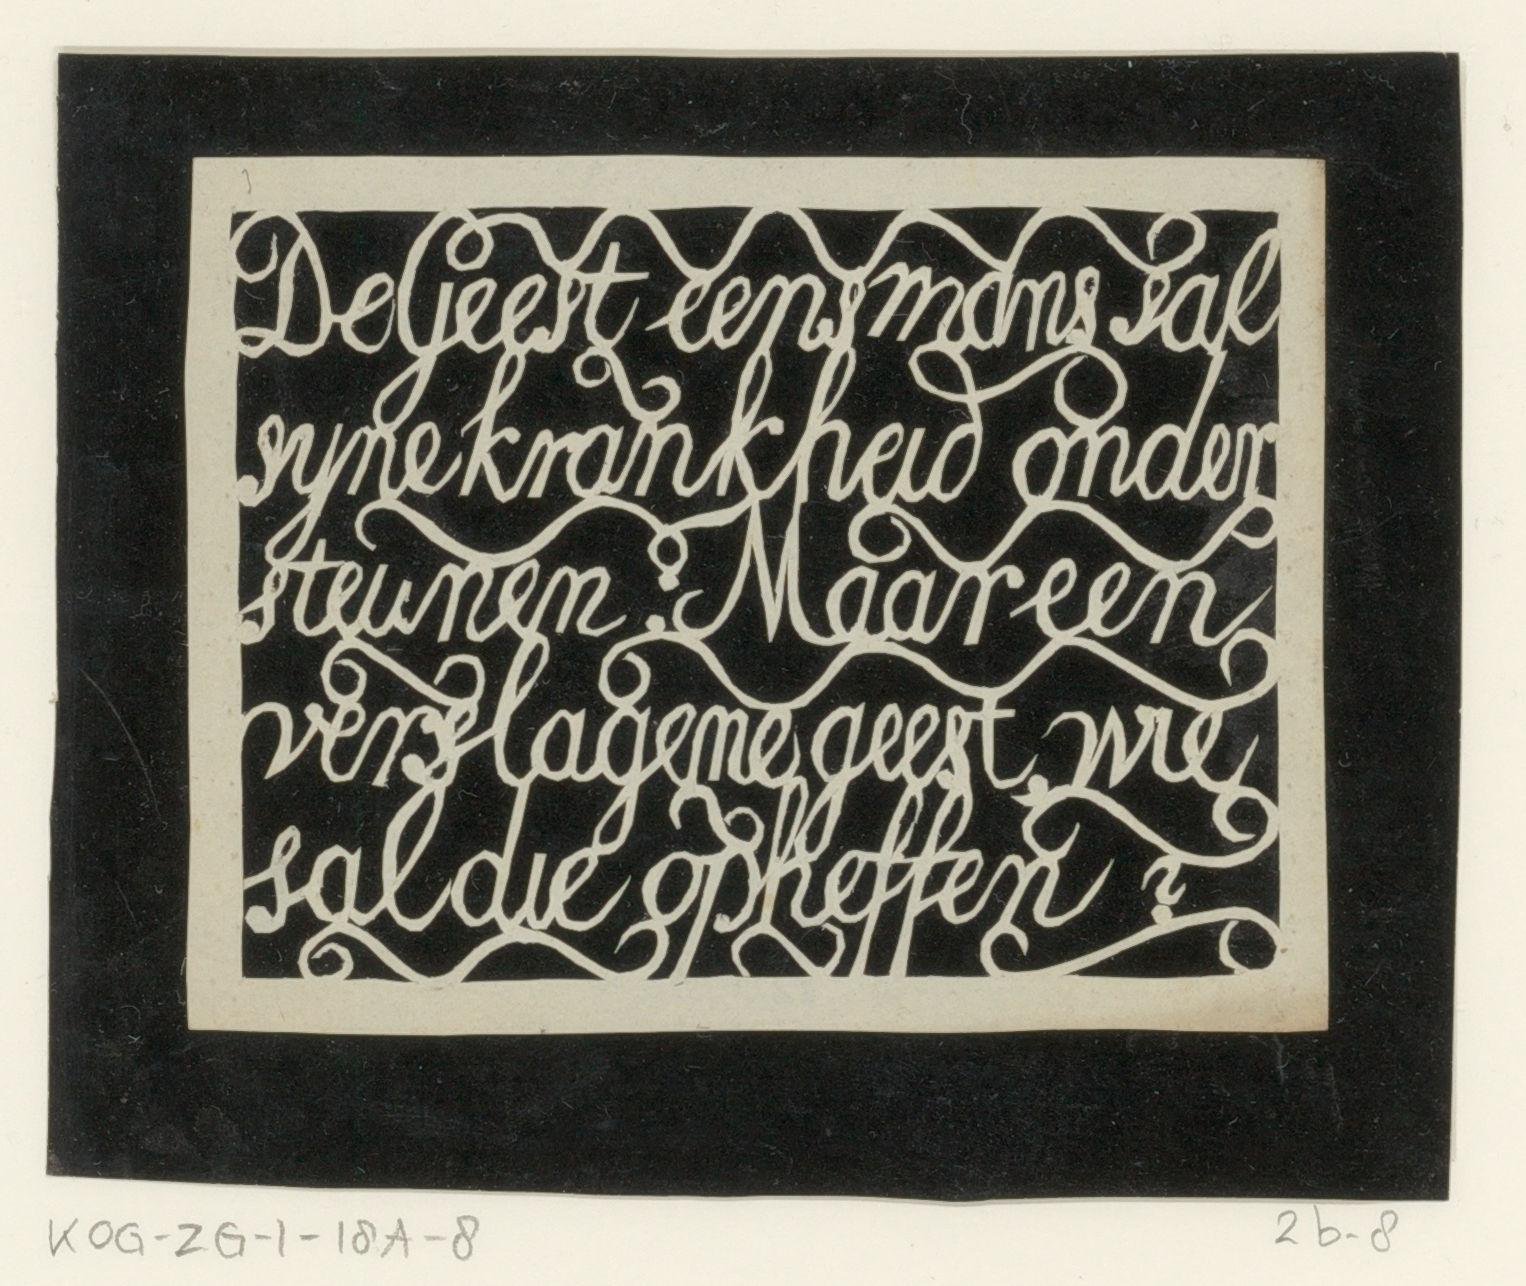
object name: cut paper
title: Spreuk: De Geest eens mans sal sijne Krankheid ondersteunen: Maar een verslagene geest, wie sal die opheffen?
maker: Anonymous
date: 1750-1849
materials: paper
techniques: cutting, snipping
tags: word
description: Onderwerpsrubrieken binnen de Atlas Zeden en Gewoonten: Schoone kunsten, Knipkunst.